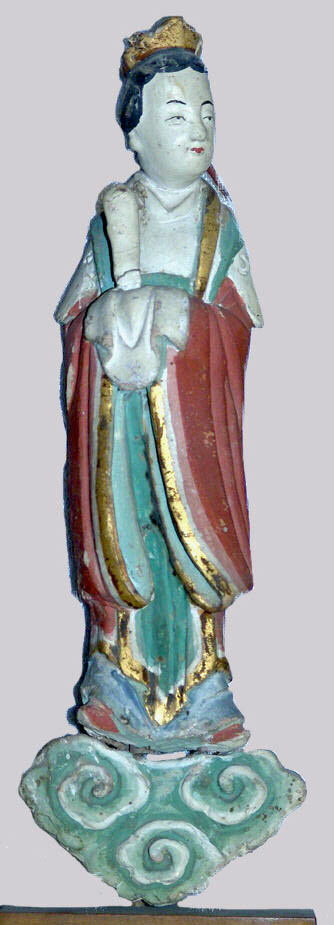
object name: statuette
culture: chinese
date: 1601-1700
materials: mud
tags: men